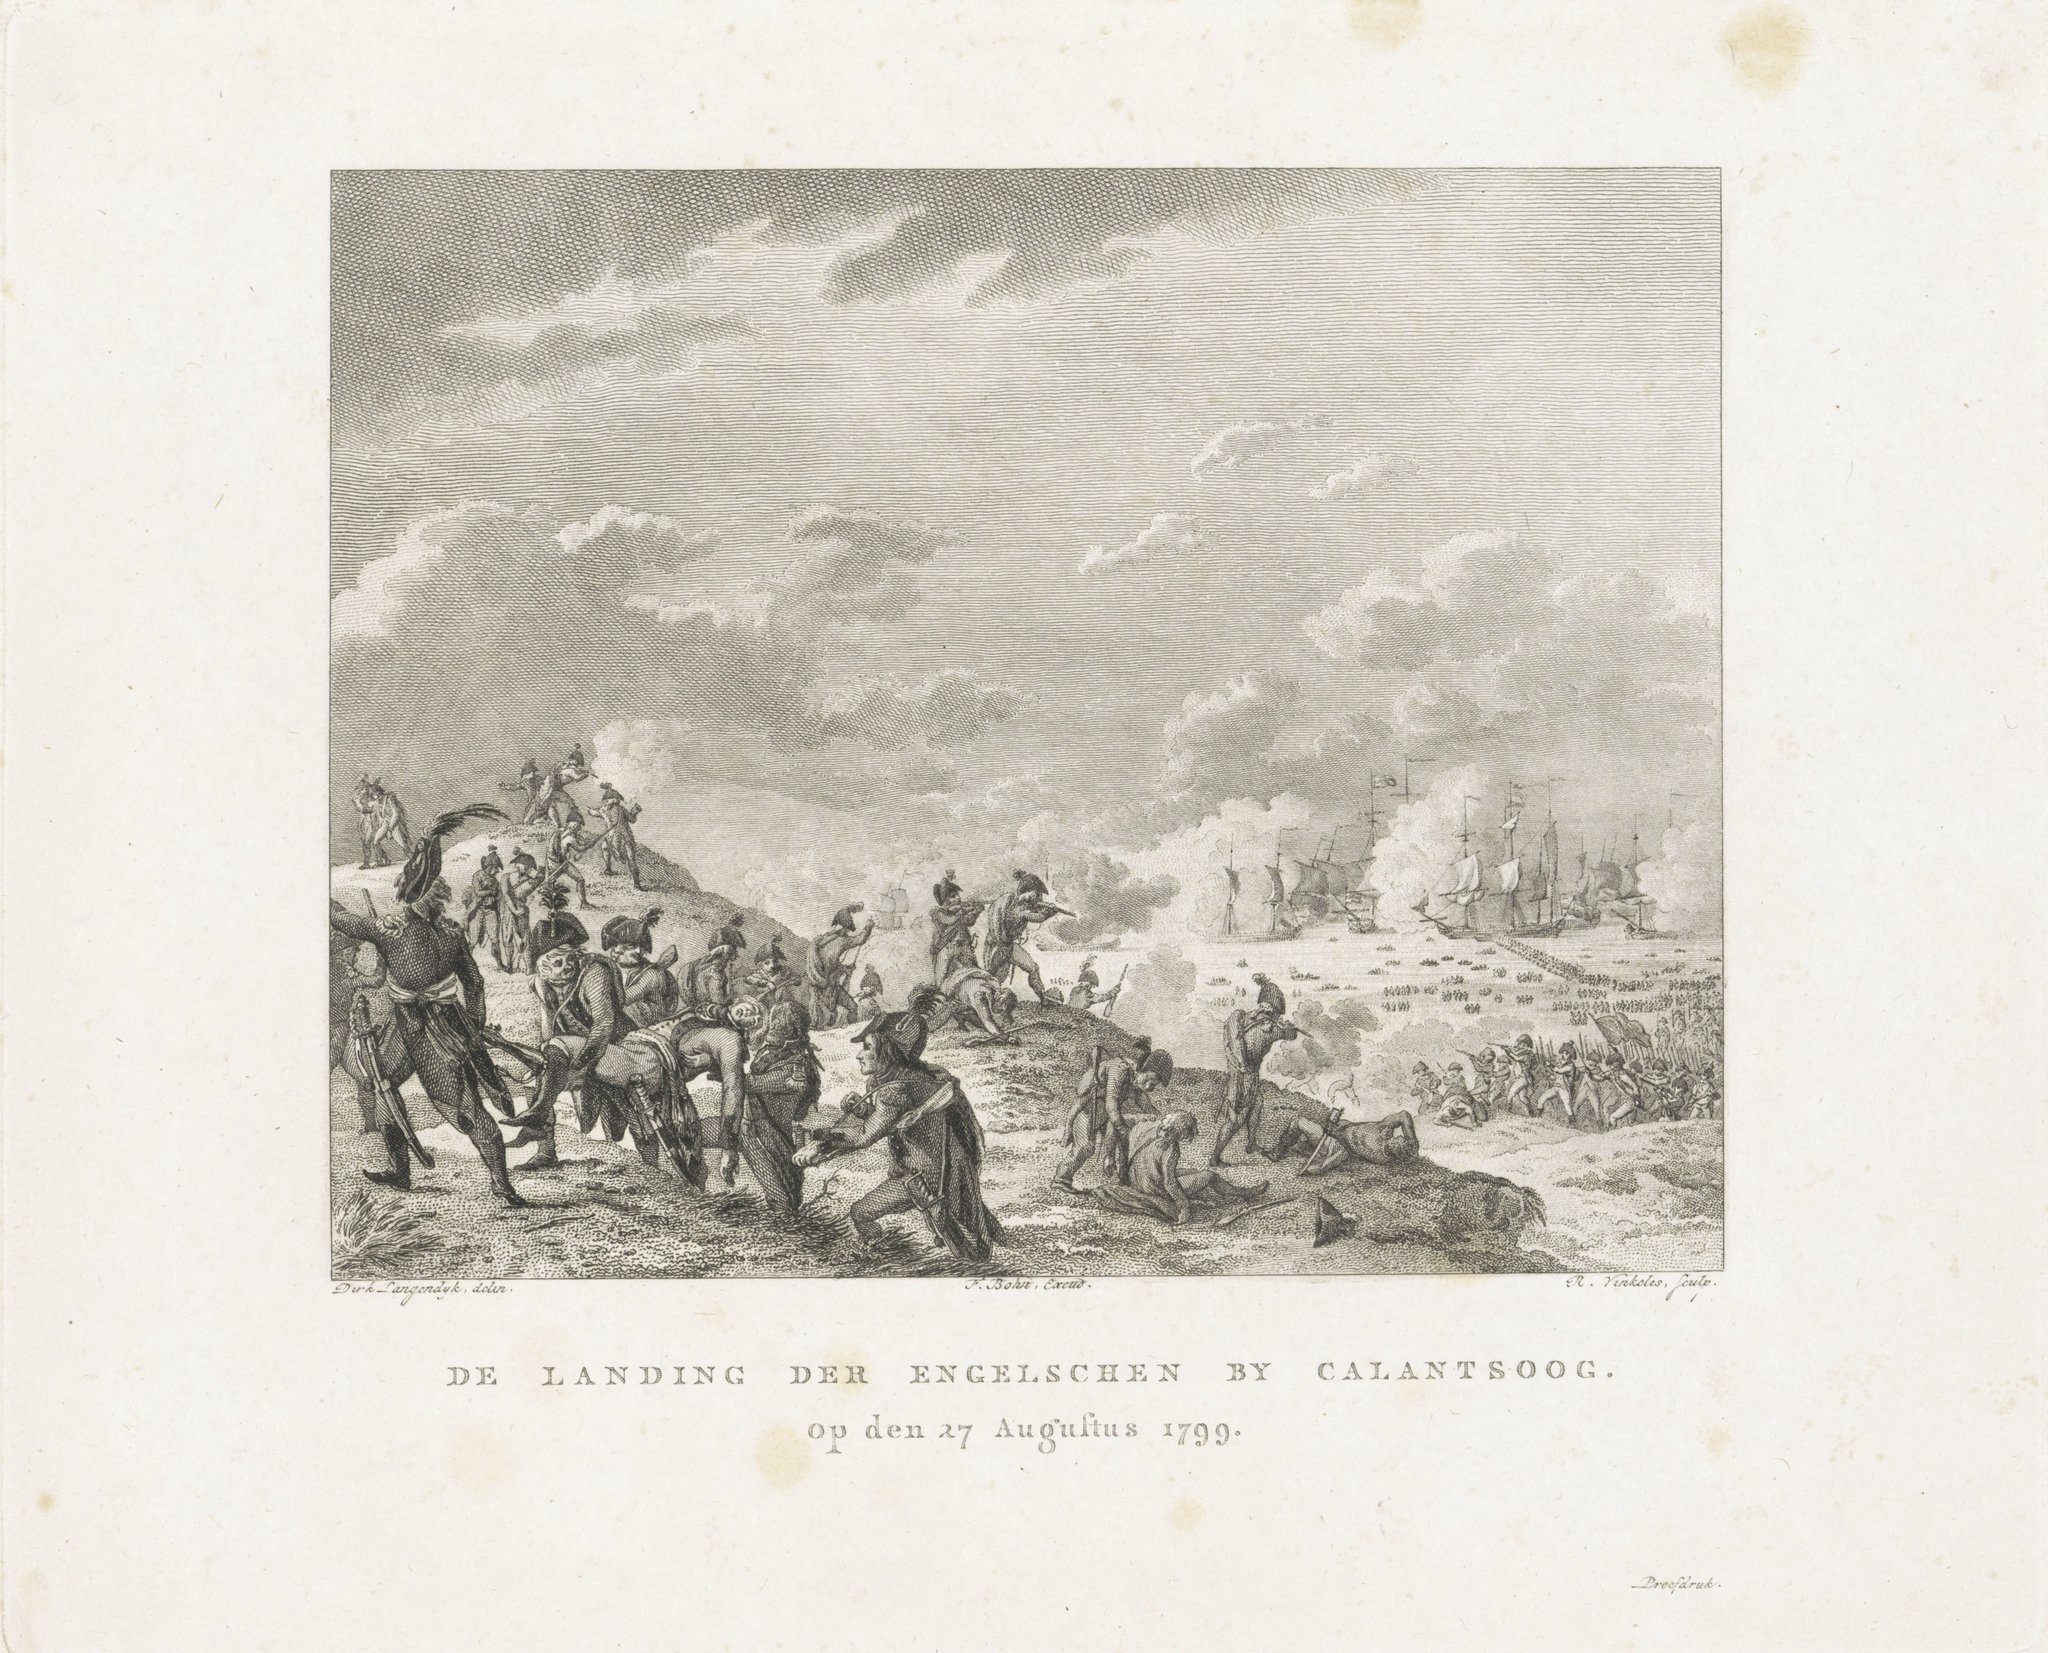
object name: print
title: De Landing der Engelschen by Callantsoog. Op den 27 Augustus 1799.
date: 1800-1802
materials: paper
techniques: engraving, etching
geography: haarlem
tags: (military) attack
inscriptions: collector's mark: Lugt 240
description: Gebruikt als illustratie in: L.C. Vonk. Geschiedenis der landing van het Engelsch-Russisch leger in Noord-Holland; alsmede der krijgsbedrijven en politieke gebeurtenissen, zoo aldaar, als in Vriesland en Gelderland, in den jare 1799. Haarlem: François Bohn, 2 dln, 1801-1802.